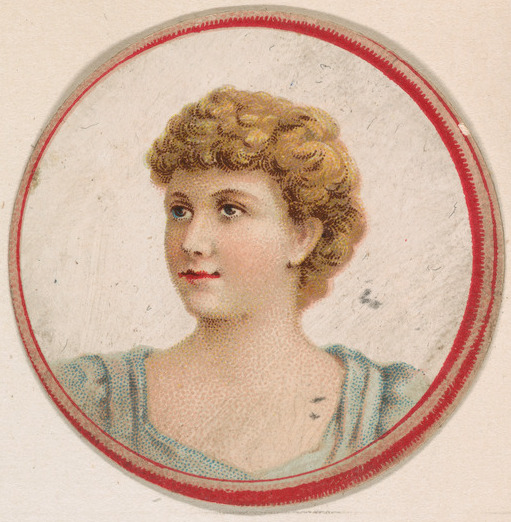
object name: print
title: Portrait of woman, from the Novelties series (N228, Type 2) issued by Kinney Bros.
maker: kinney brothers tobacco company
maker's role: publisher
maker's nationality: american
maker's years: 1869-2011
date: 1889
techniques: color lithograph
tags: portraits,women